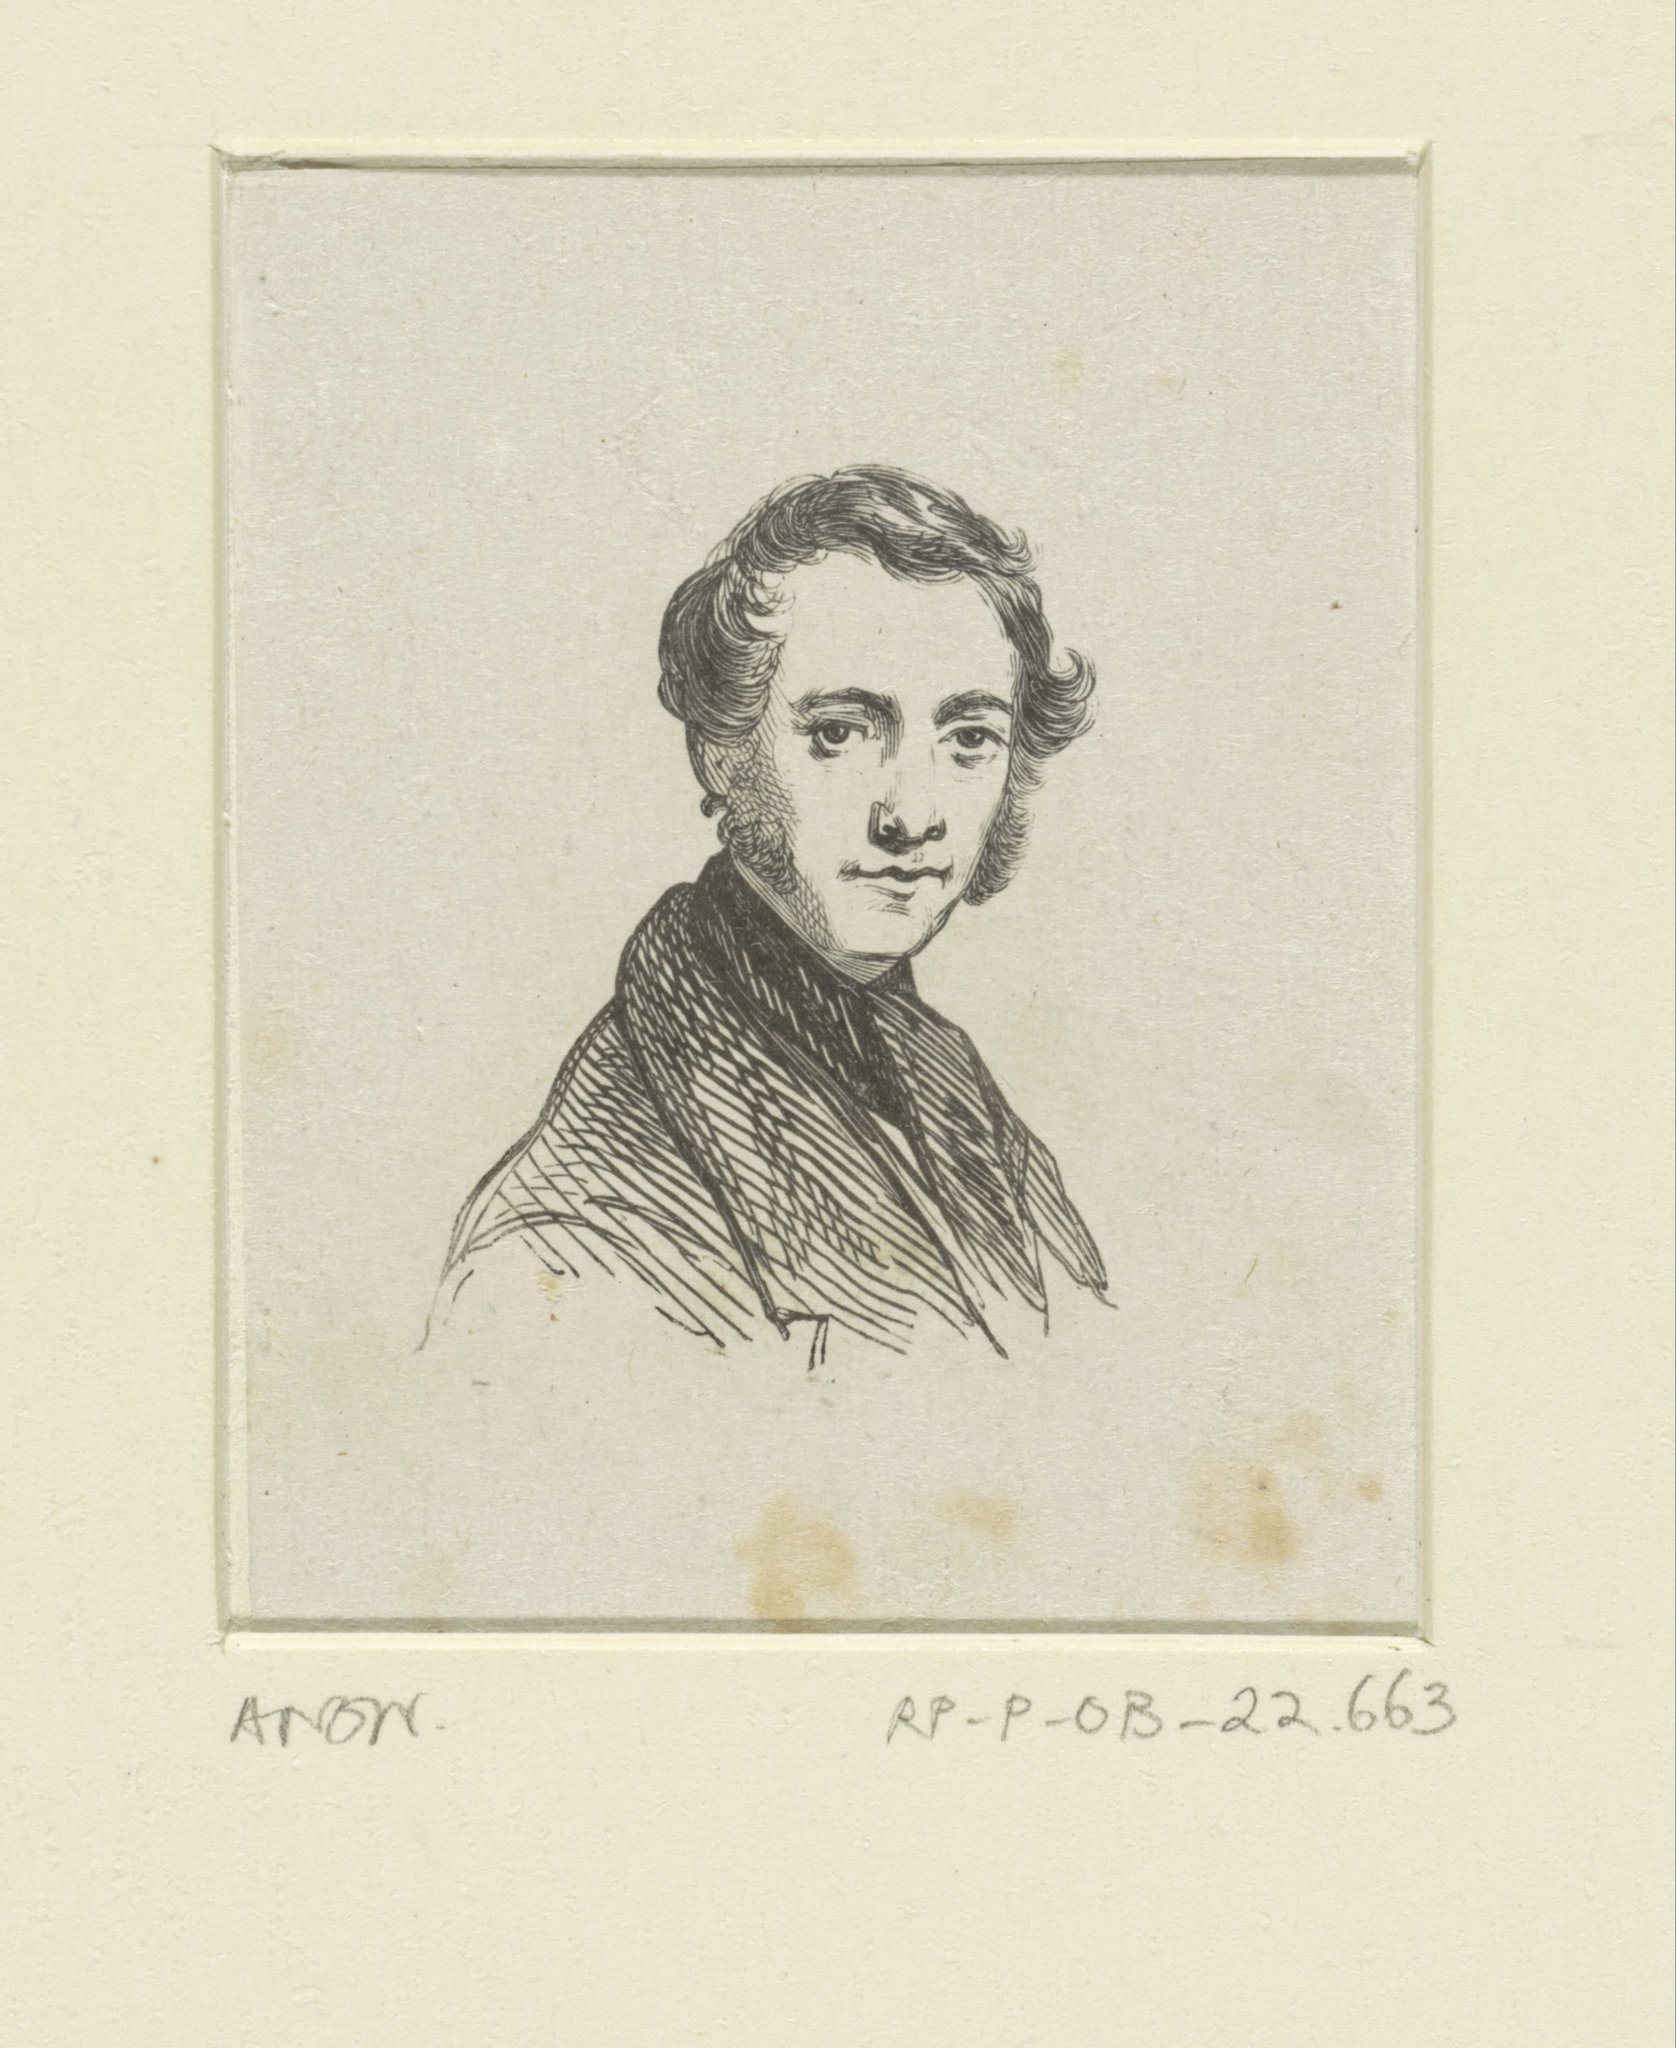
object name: print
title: Portret van Hendrikus van de Sande Bakhuyzen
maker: Anonymous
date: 1805-1910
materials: paper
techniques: engraving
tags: the hague, painter, print maker, draughtsman, hendrikus van de sande bakhuyzen, historical persons, portrait, self-portrait of painter, portrait, self-portrait of artist